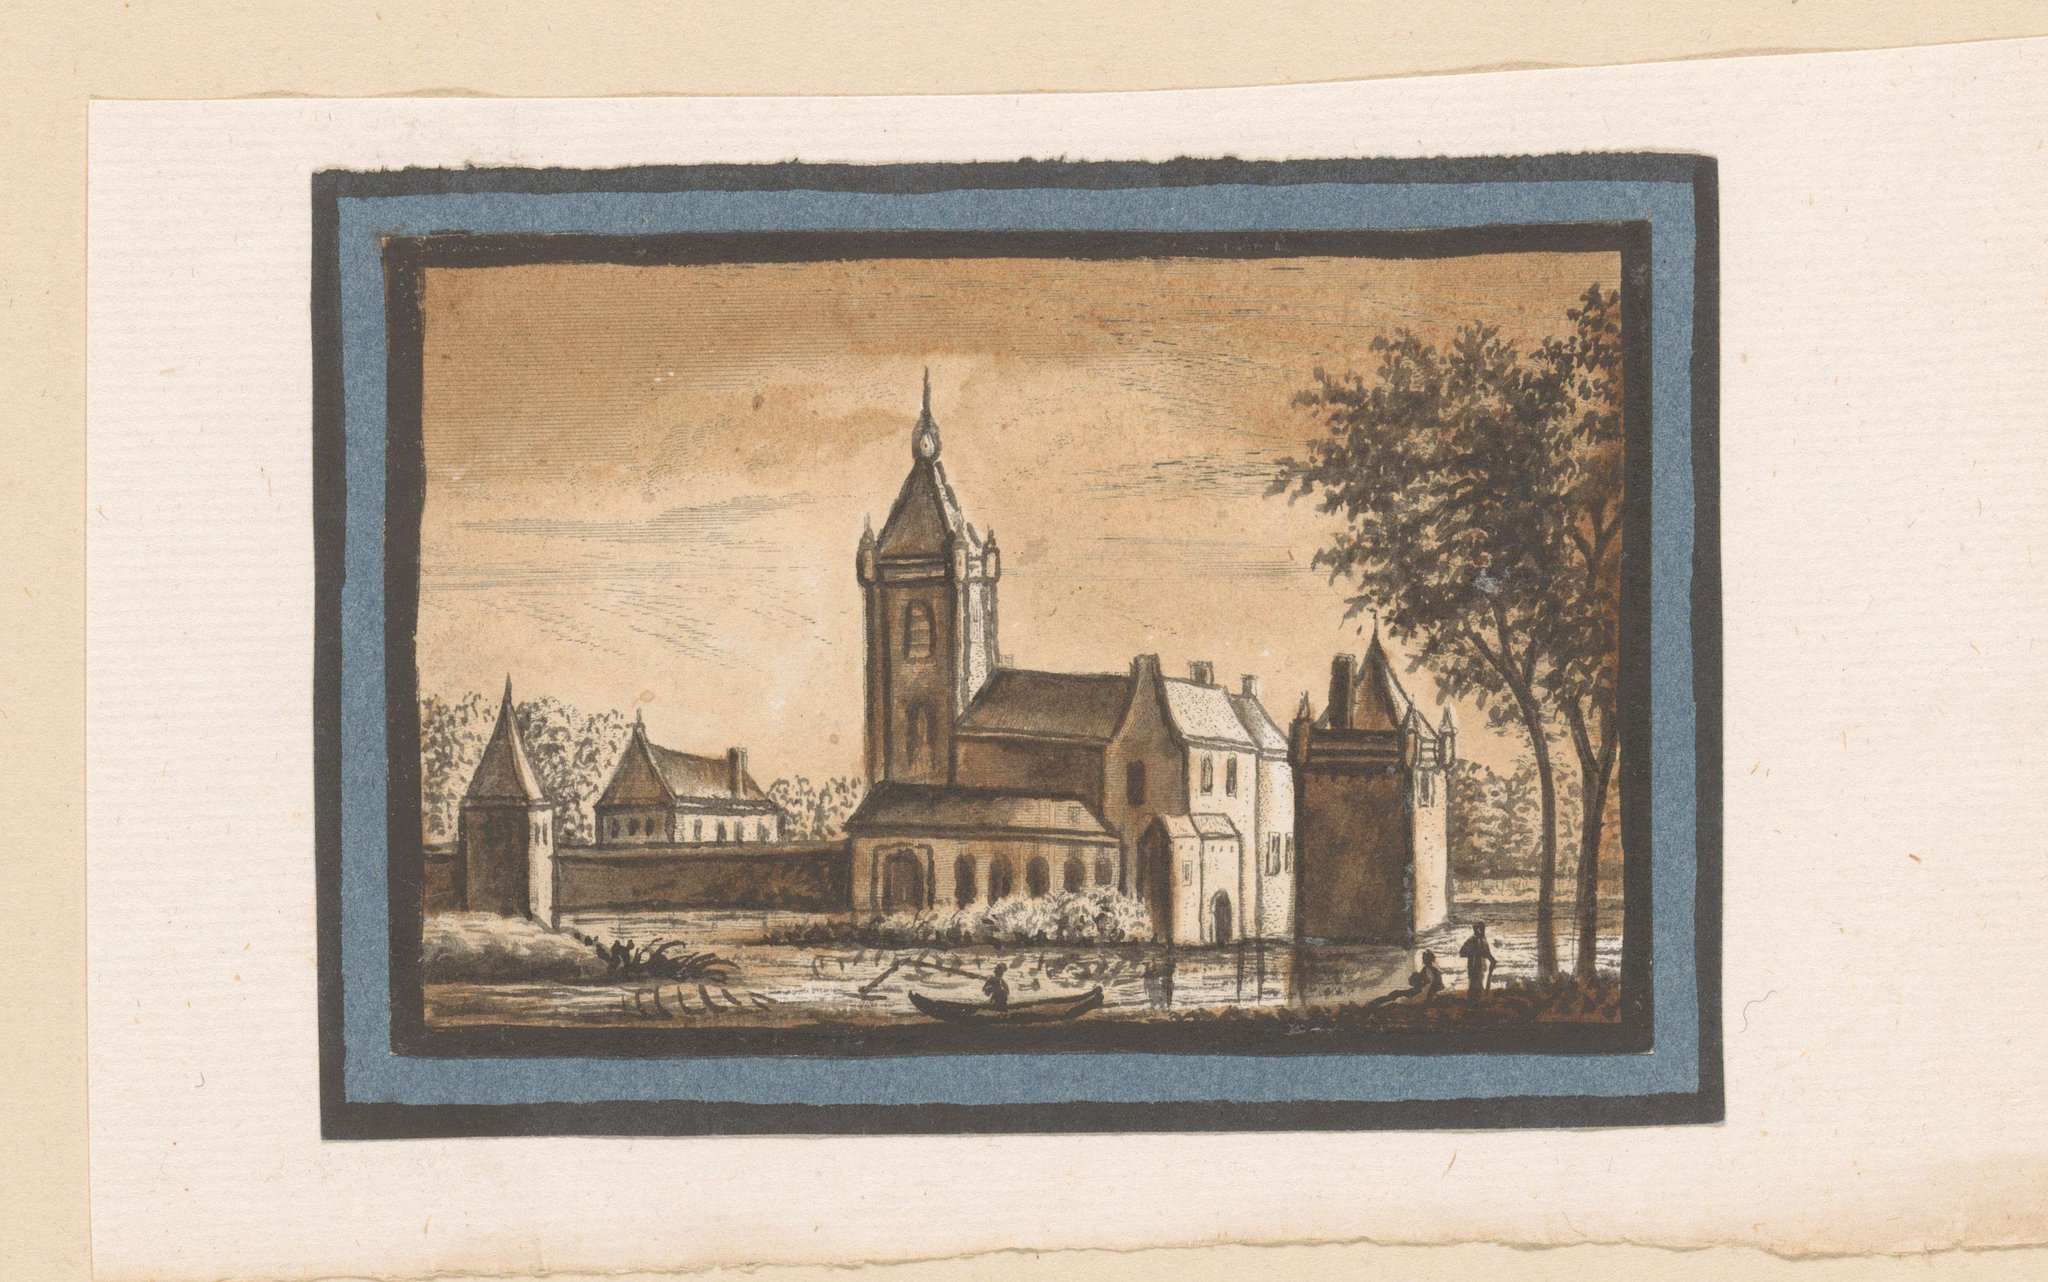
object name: drawing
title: Gezicht op het kasteel van Montfoort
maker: Anonymous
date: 1725-1750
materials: ink, paper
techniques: brush, pen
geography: amsterdam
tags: castle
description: Naar prent uit: Rademaker, Abraham. Kabinet van Nederlandsche outheden en gezichten: vervat in 300 konstplaten. Amsterdam: Willem Barents, 1725.